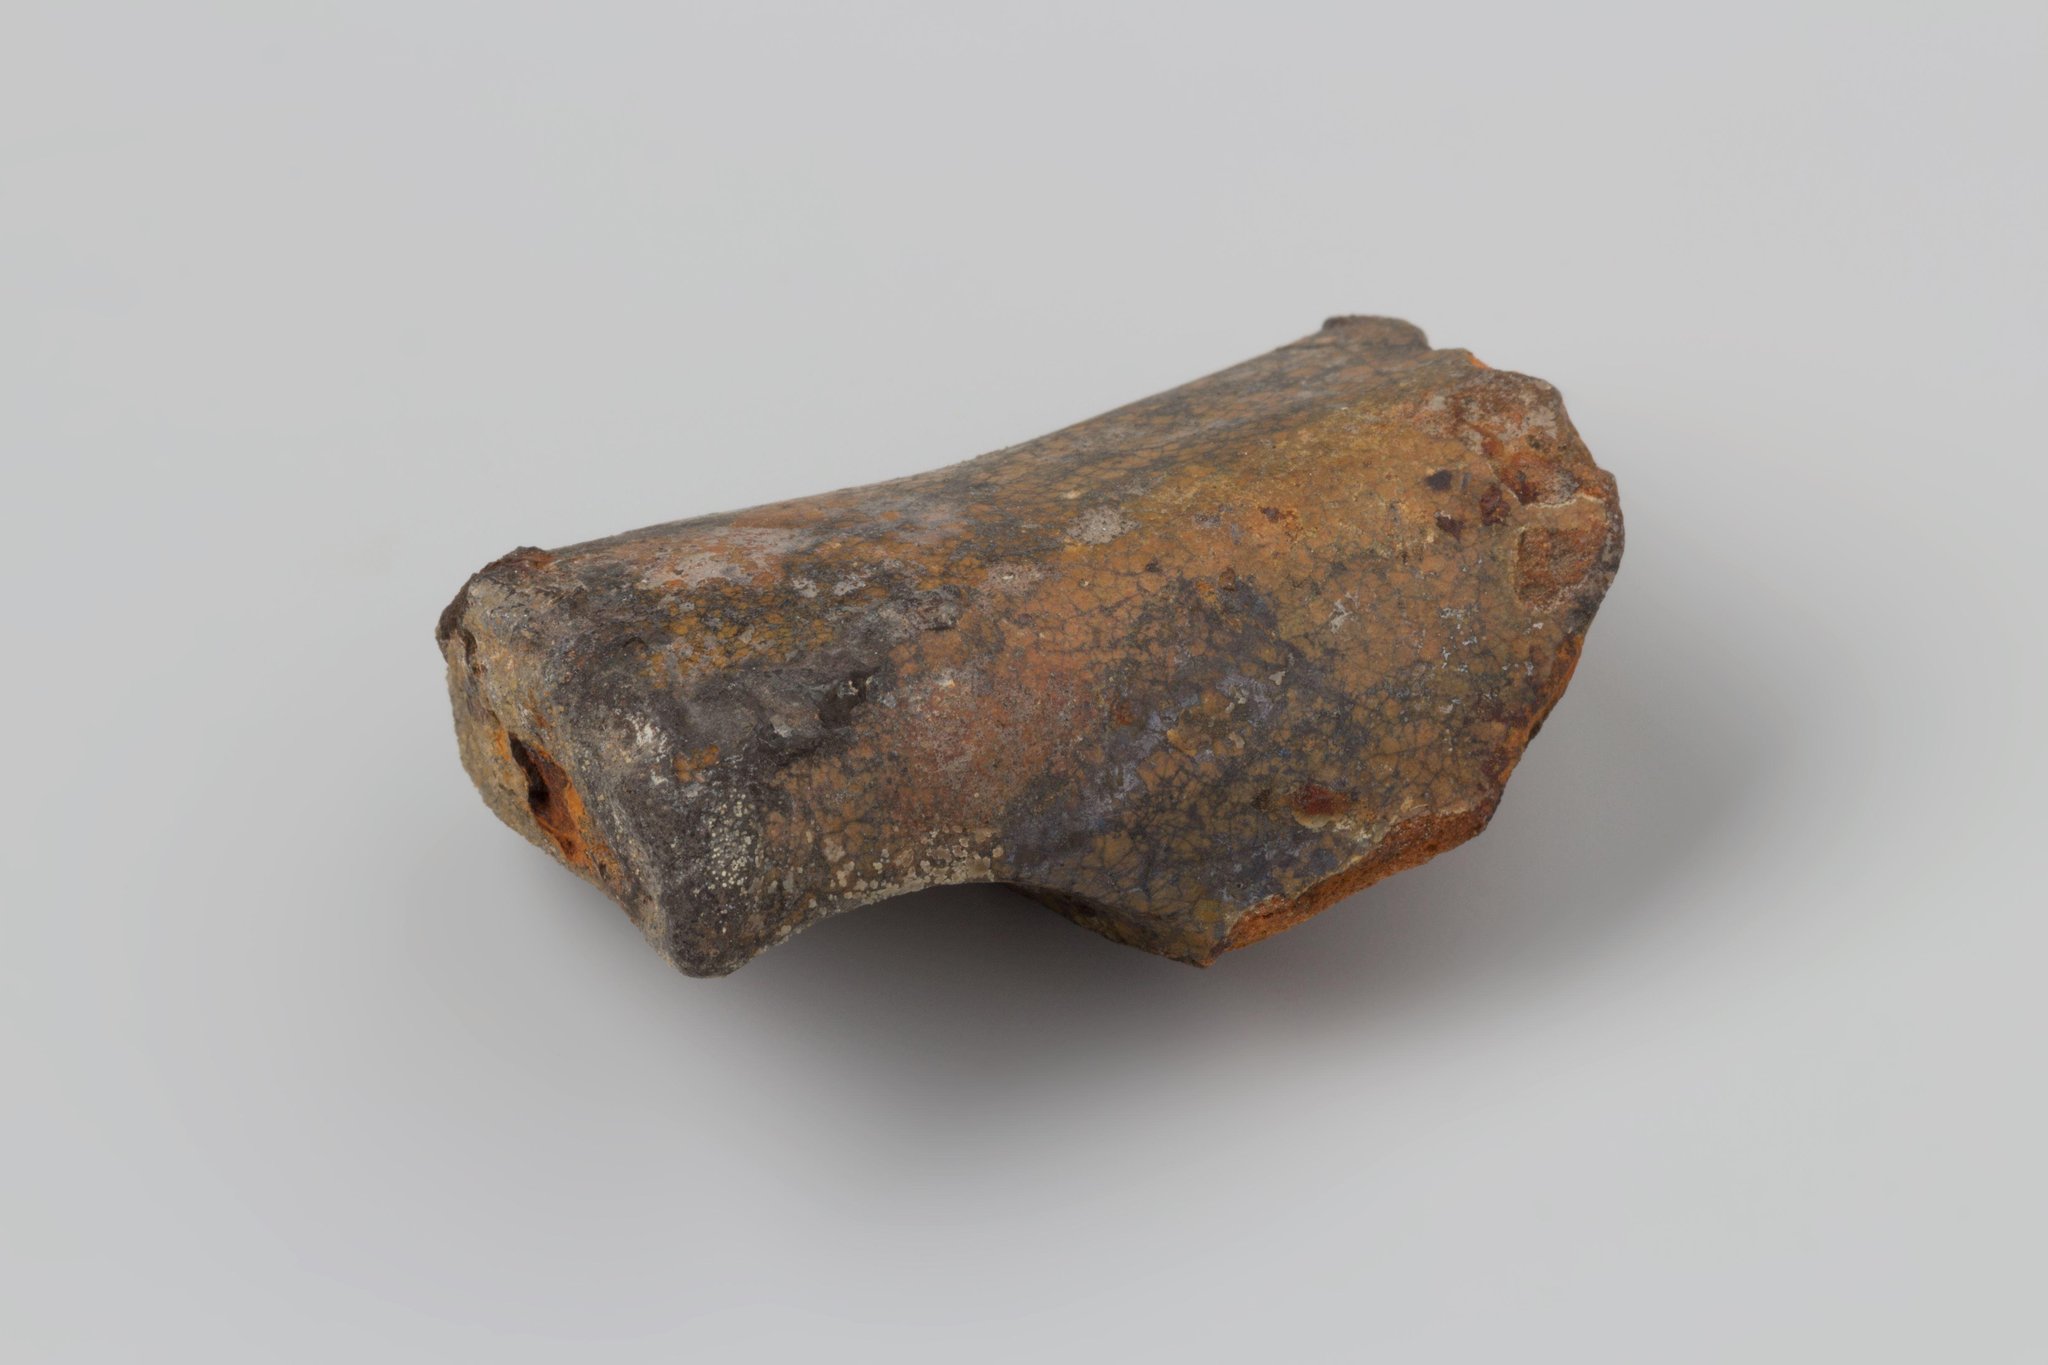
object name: sherd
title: Scherf aardewerk uit het wrak van de Oost-Indiëvaarder 't Vliegend Hart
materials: earthenware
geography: netherlands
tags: 't vliegend hart (schip), verenigde oostindische compagnie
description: Halfrond langwerpig oor van roodbakkend aardewerk dat aan beide zijden is afgebroken met een roestige kern.